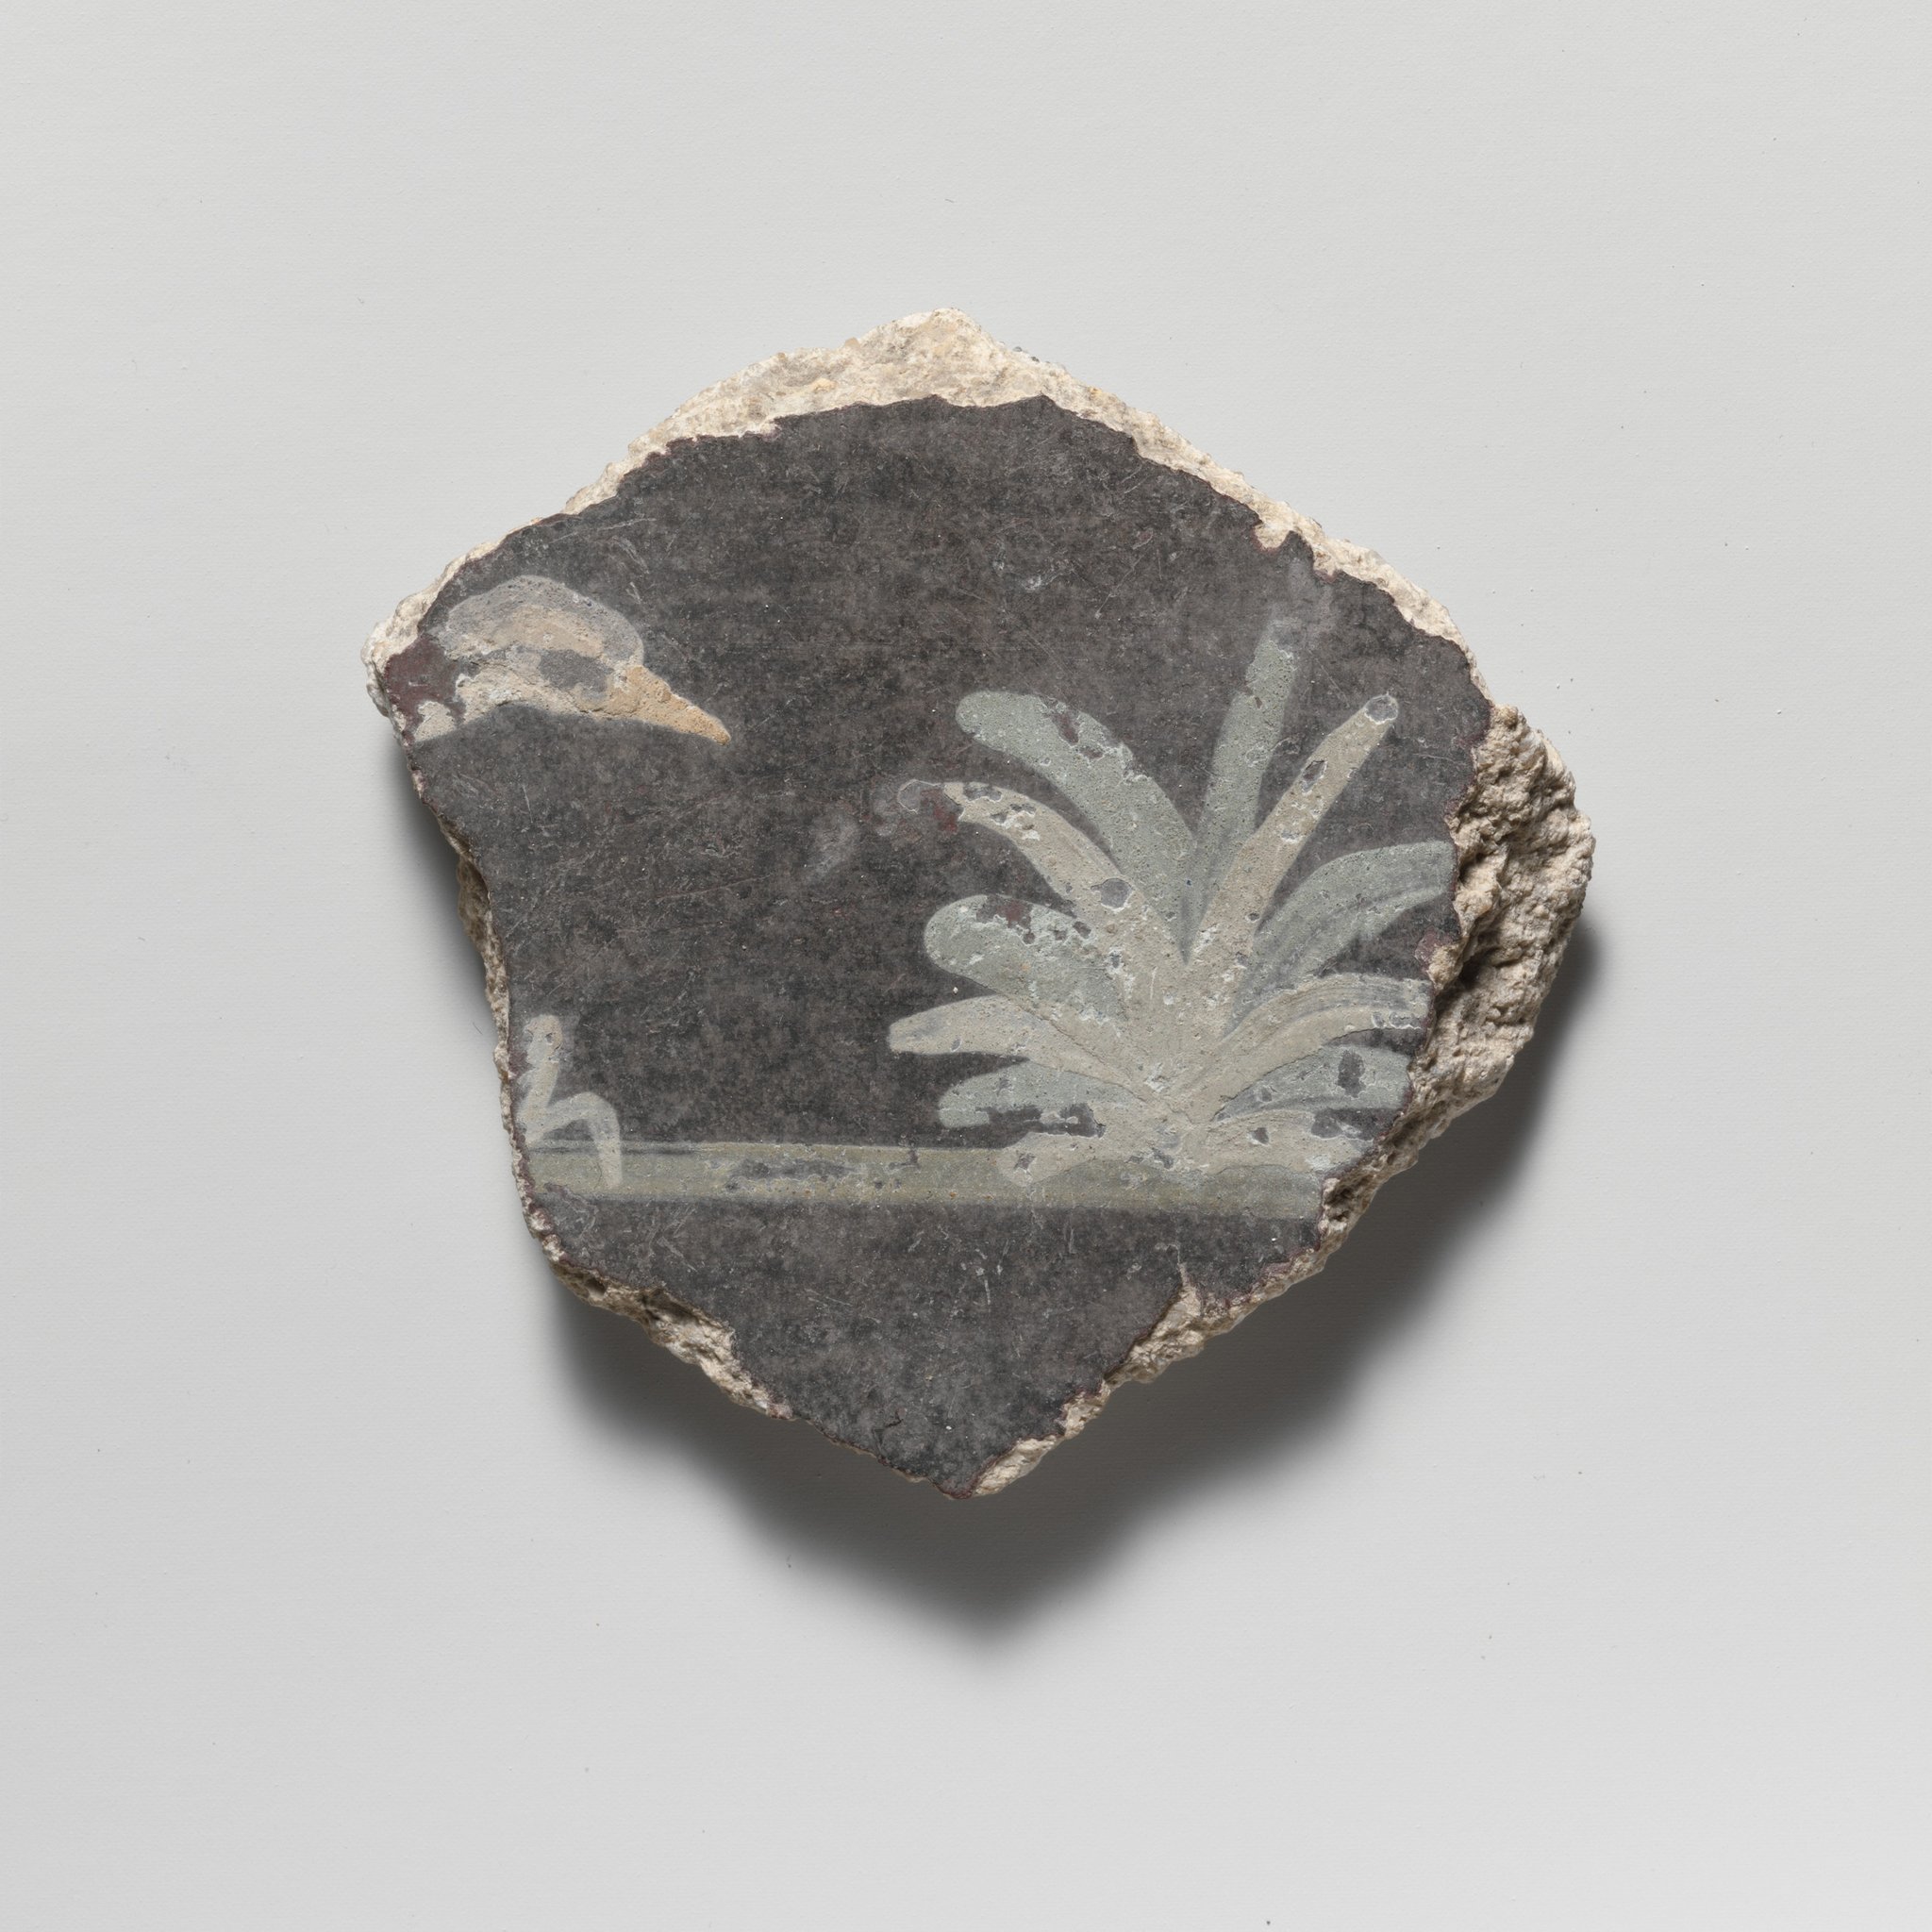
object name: wall painting fragment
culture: roman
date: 1-100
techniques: fresco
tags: birds